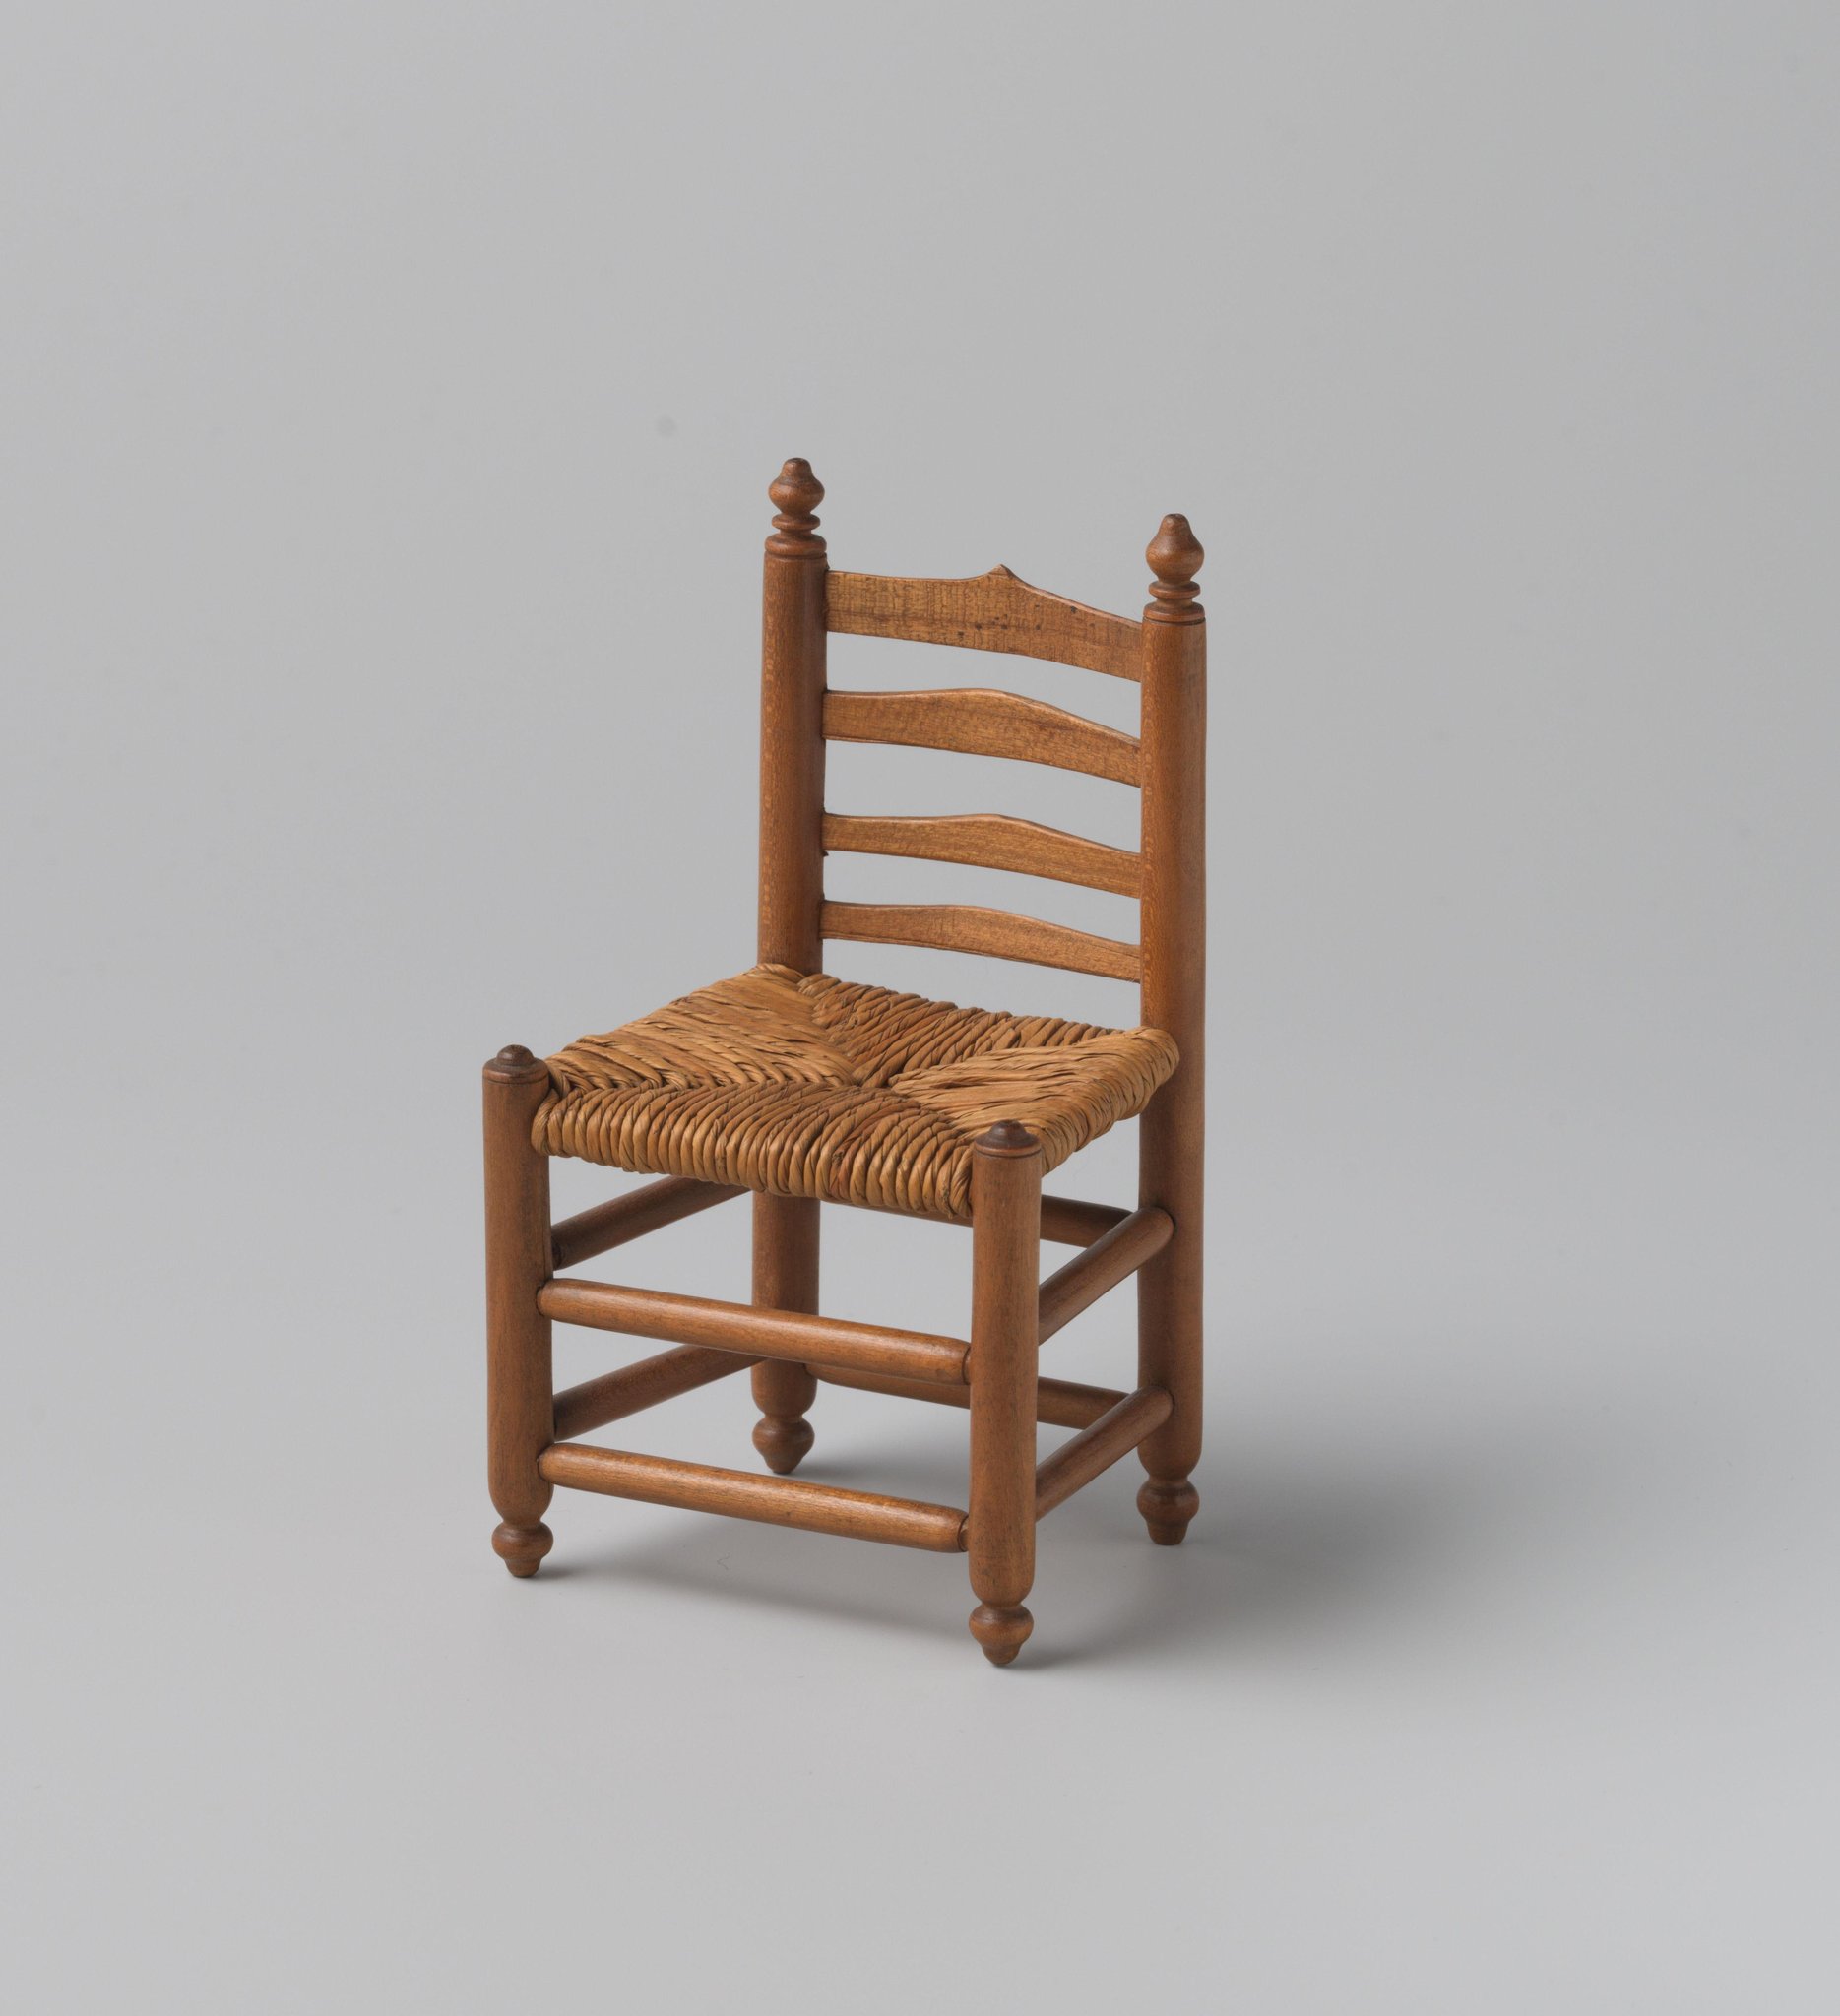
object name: knopstoel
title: Knopstoel met zitting van gevlochten biezen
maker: Anonymous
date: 1690-1710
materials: wood, fiber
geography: amsterdam